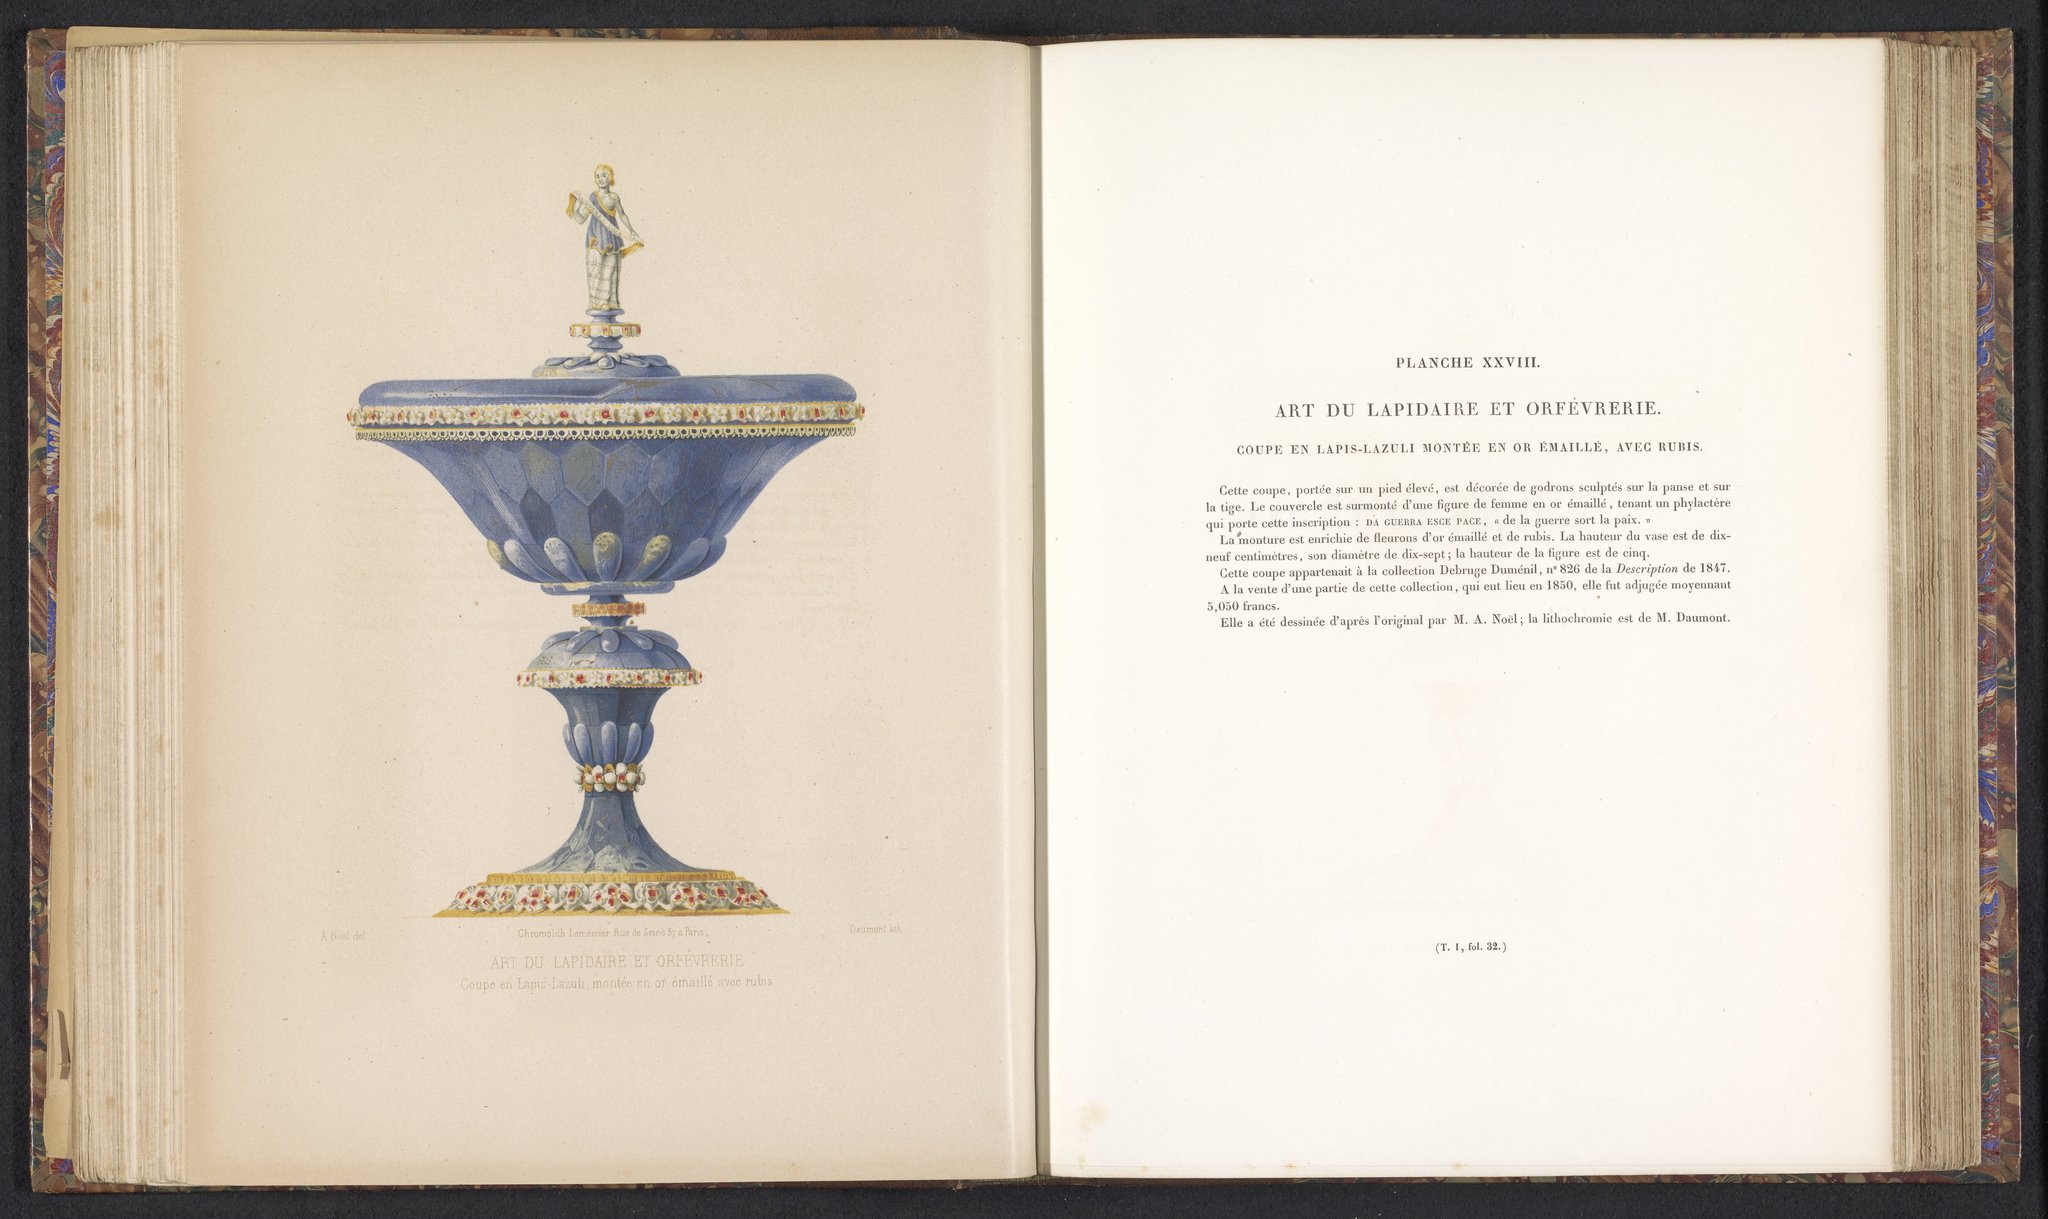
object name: print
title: Kelk uit lapis lazuli met goud en robijnen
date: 1859-1864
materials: paper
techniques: chromolithography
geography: paris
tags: chalice